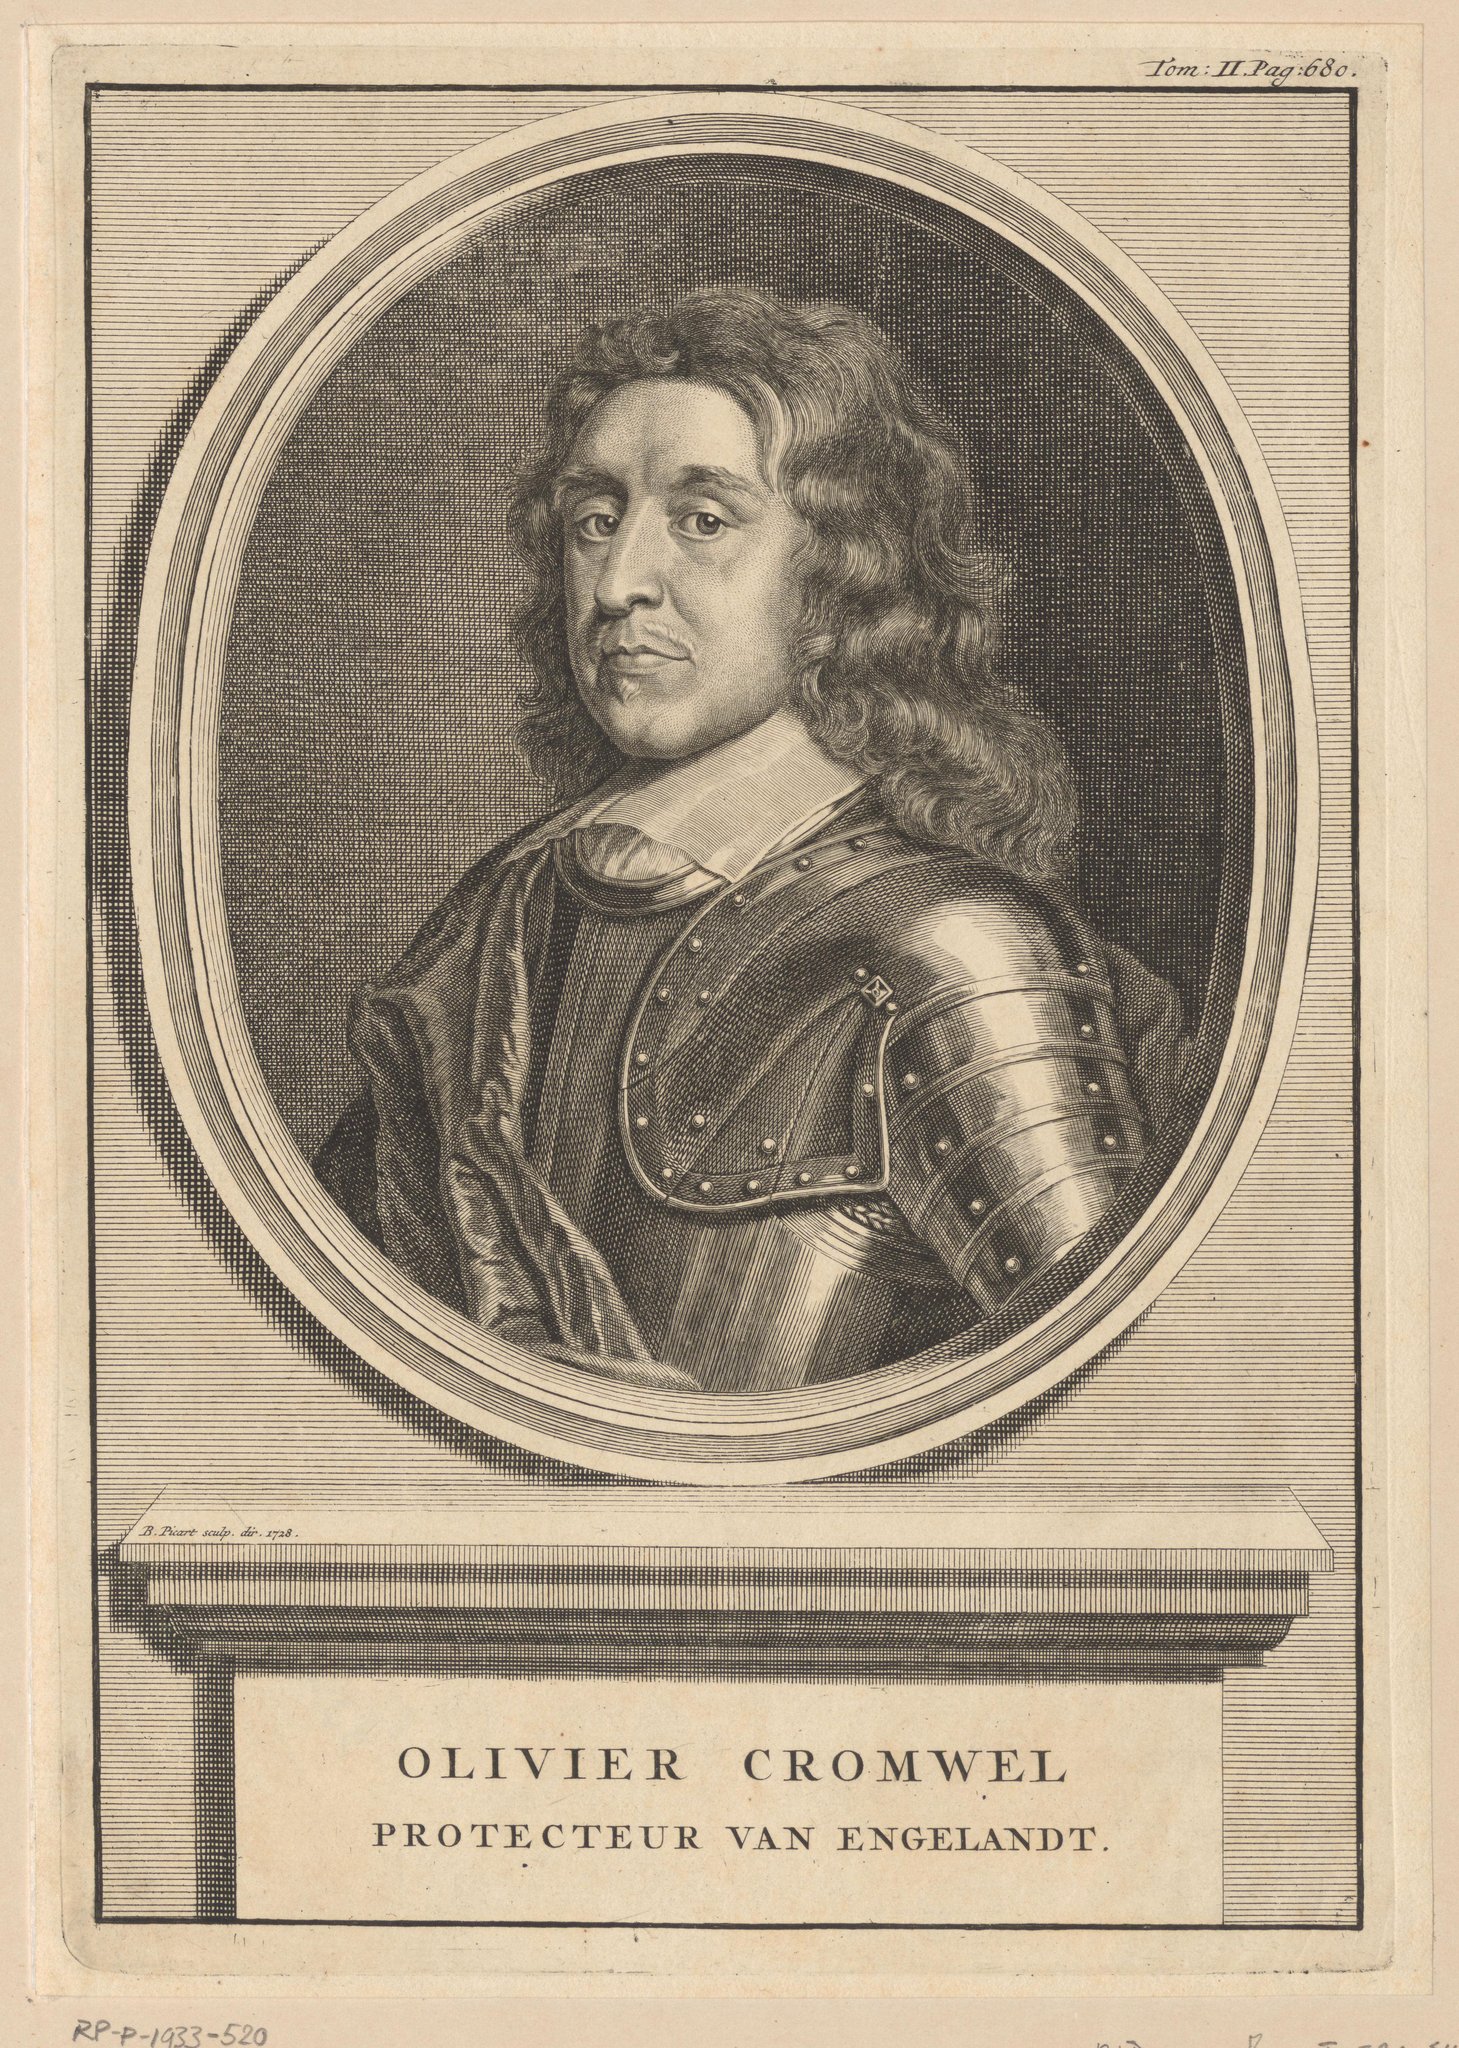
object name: print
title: Portret van Oliver Cromwell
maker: bernard picart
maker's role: draughtsman, print maker, publisher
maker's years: 1673-1733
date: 1728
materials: paper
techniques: engraving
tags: london, oliver cromwell, historical persons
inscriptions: date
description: Prent mogelijk uit: Clerc, Jean le. Geschiedenissen der Vereenigde Nederlanden (...). Amsterdam: Zacharias Chatelain, 1730, dl. 2.